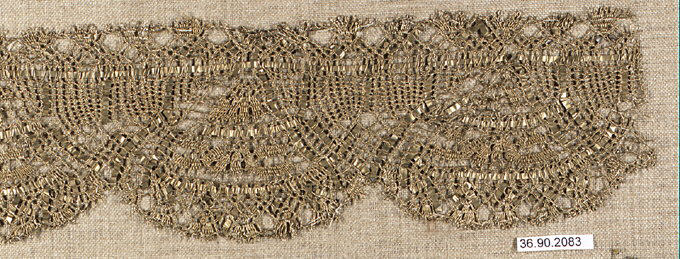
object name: piece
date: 1701-1800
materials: metal thread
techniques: lace